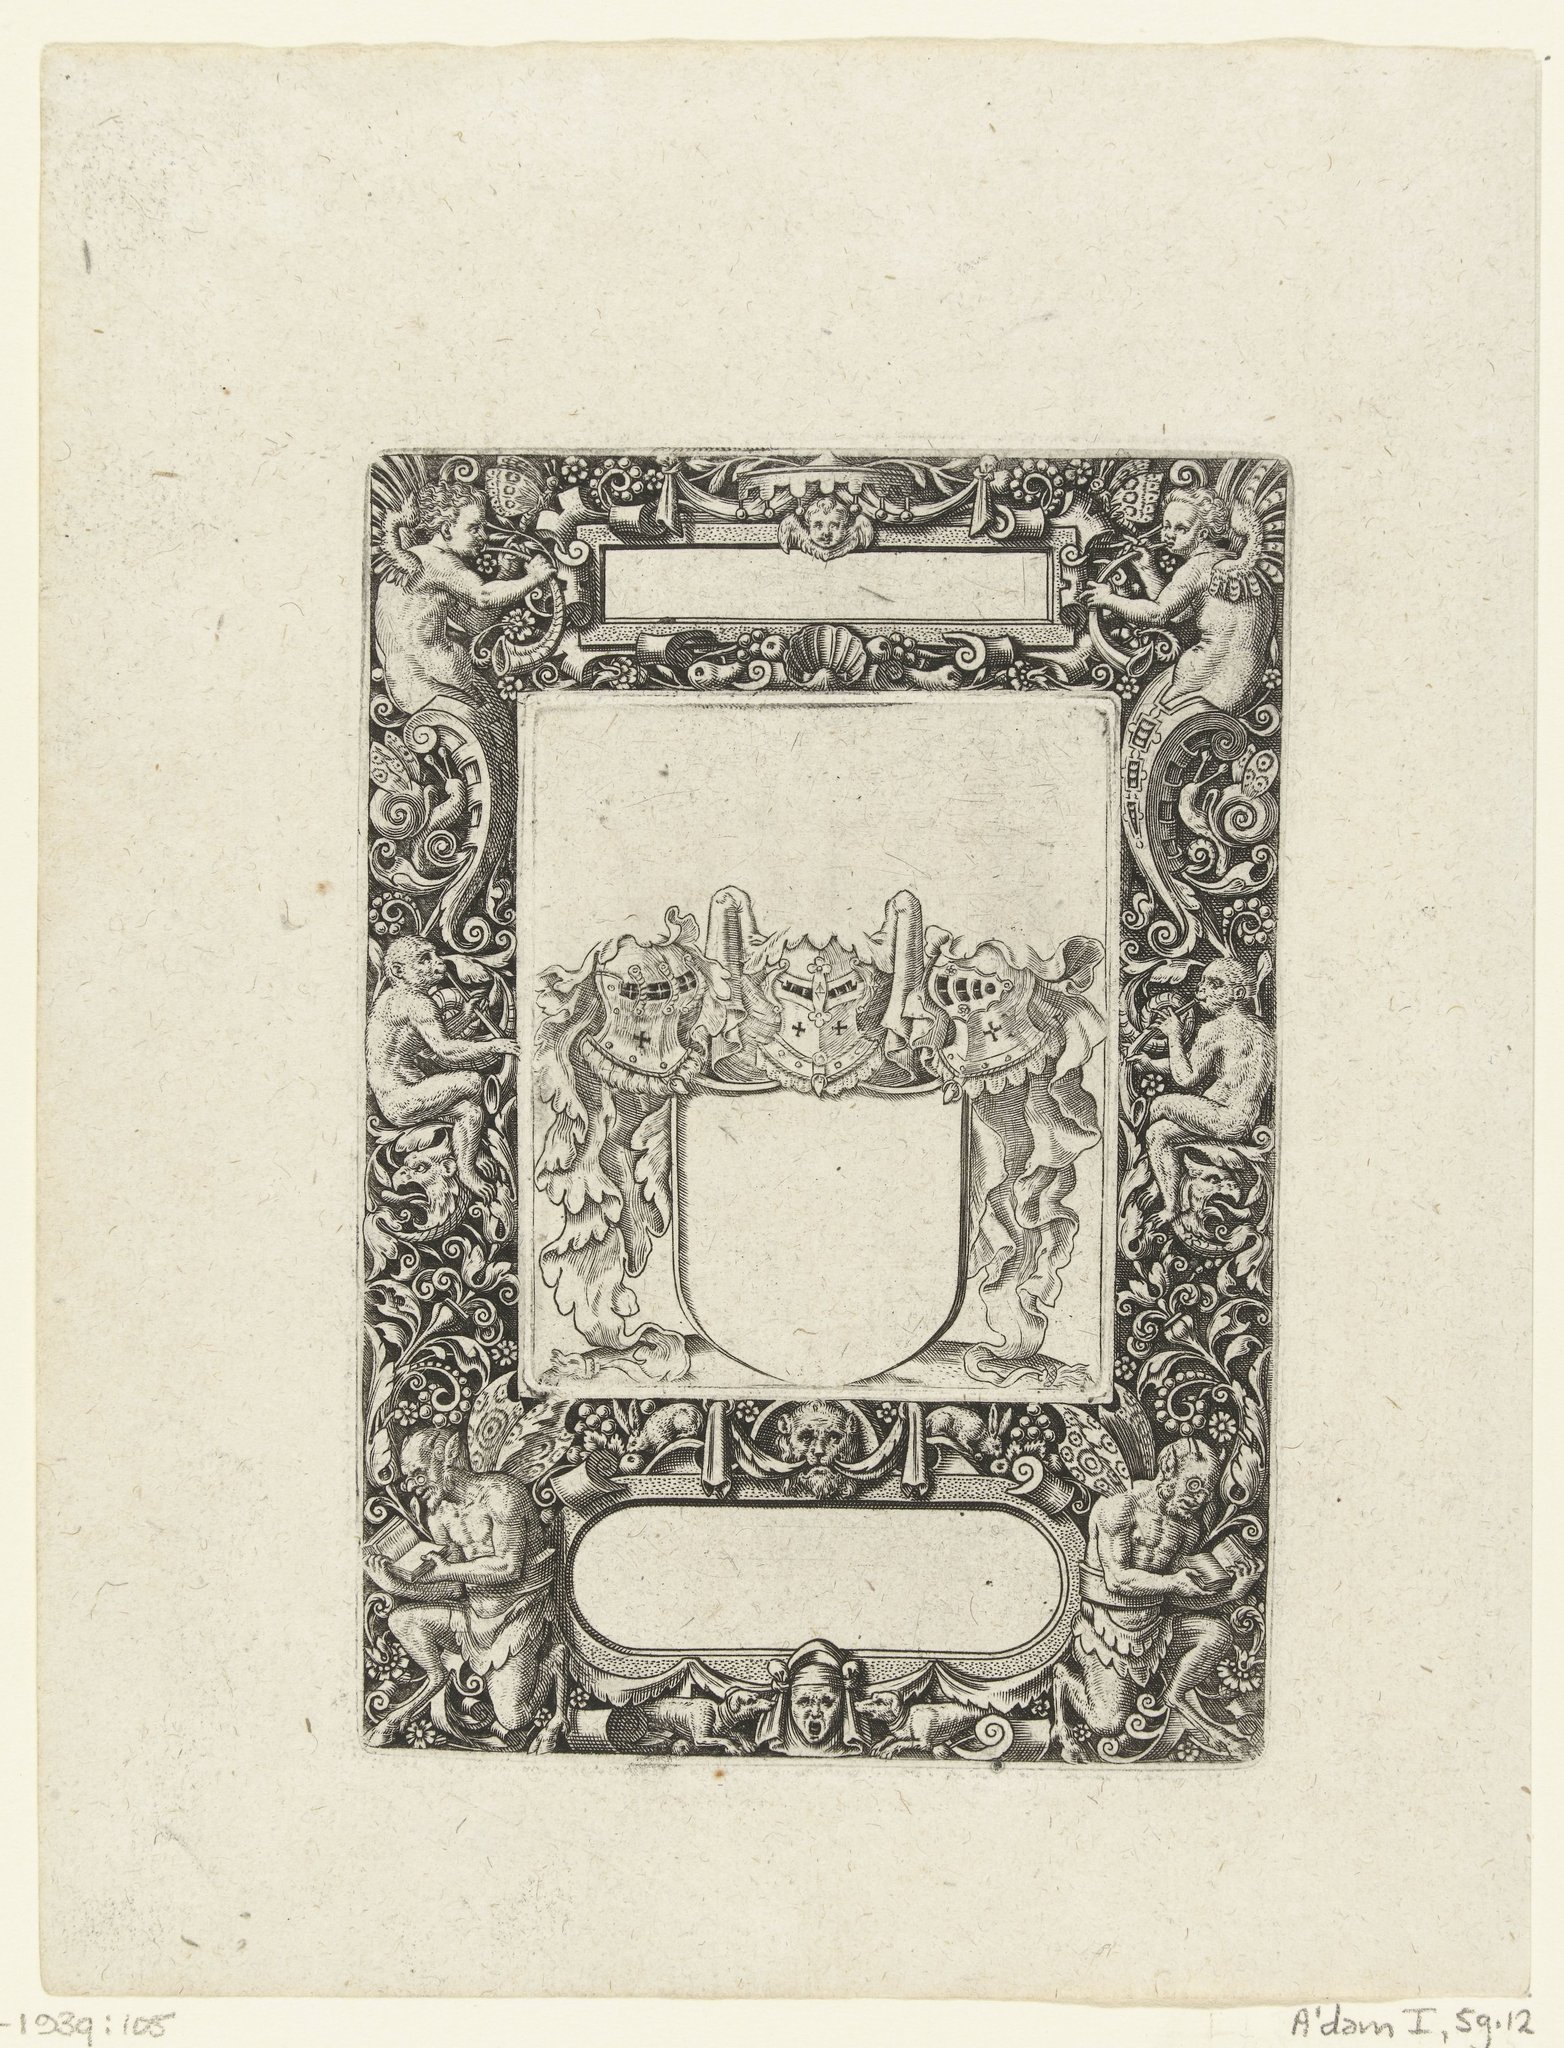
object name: ornament print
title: Omlijsting met cartouches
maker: theodor de bry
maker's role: draughtsman, print maker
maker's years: 1528-1598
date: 1593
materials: paper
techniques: engraving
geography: netherlands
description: Smalle rechthoekige cartouche middenboven; middenonder een cartouche met ronde zijkanten. Linksboven en rechtsboven rijst een trompetspelend engeltje op uit een voluut. Links- en rechtsonder leest een sater met een ril op een boek. Hoort bij een serie van 18 bladen waarbij in het midden van aparte platen zevenentwintig emblemata en vijfenveertig wapenschilden zijn gedrukt. De emblemata zijn ten dele genummerd A-D, 1-7 en 9-21. Drie bladen hebben geen nummer. De wapenschilden, die deels dubbel zijn afgedrukt, zijn ongenummerd.